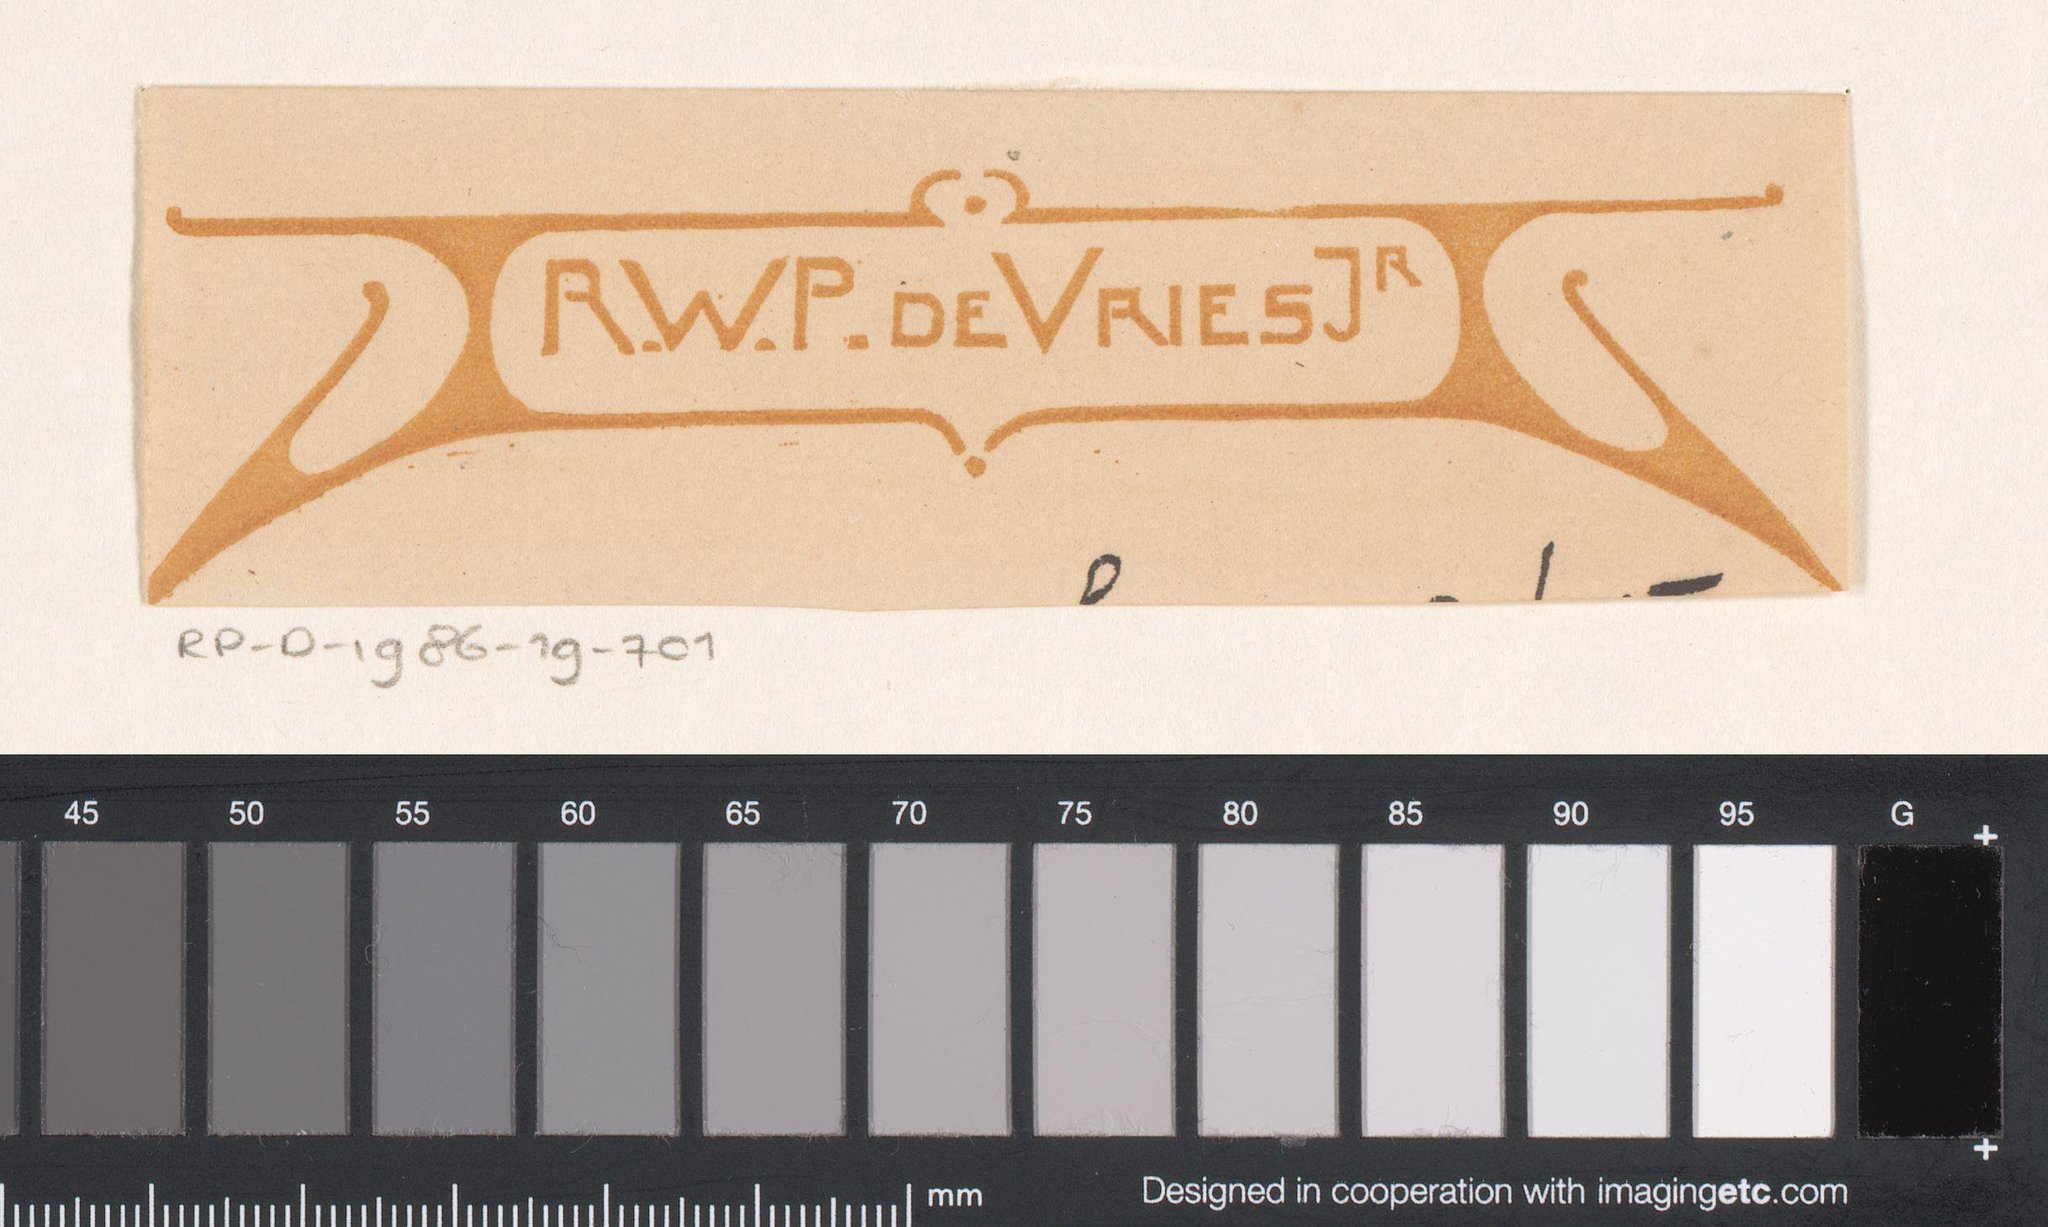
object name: print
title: Vignet R.W.P. de Vries Jr.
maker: reinier willem petrus de vries (1874-1953)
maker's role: draughtsman, print maker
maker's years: 1874-1953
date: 1884-1952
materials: paper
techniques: printing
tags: amsterdam, print maker, draughtsman, reinier willem petrus de vries (1874-1953)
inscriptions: collector's mark: ‘R:MVS.’